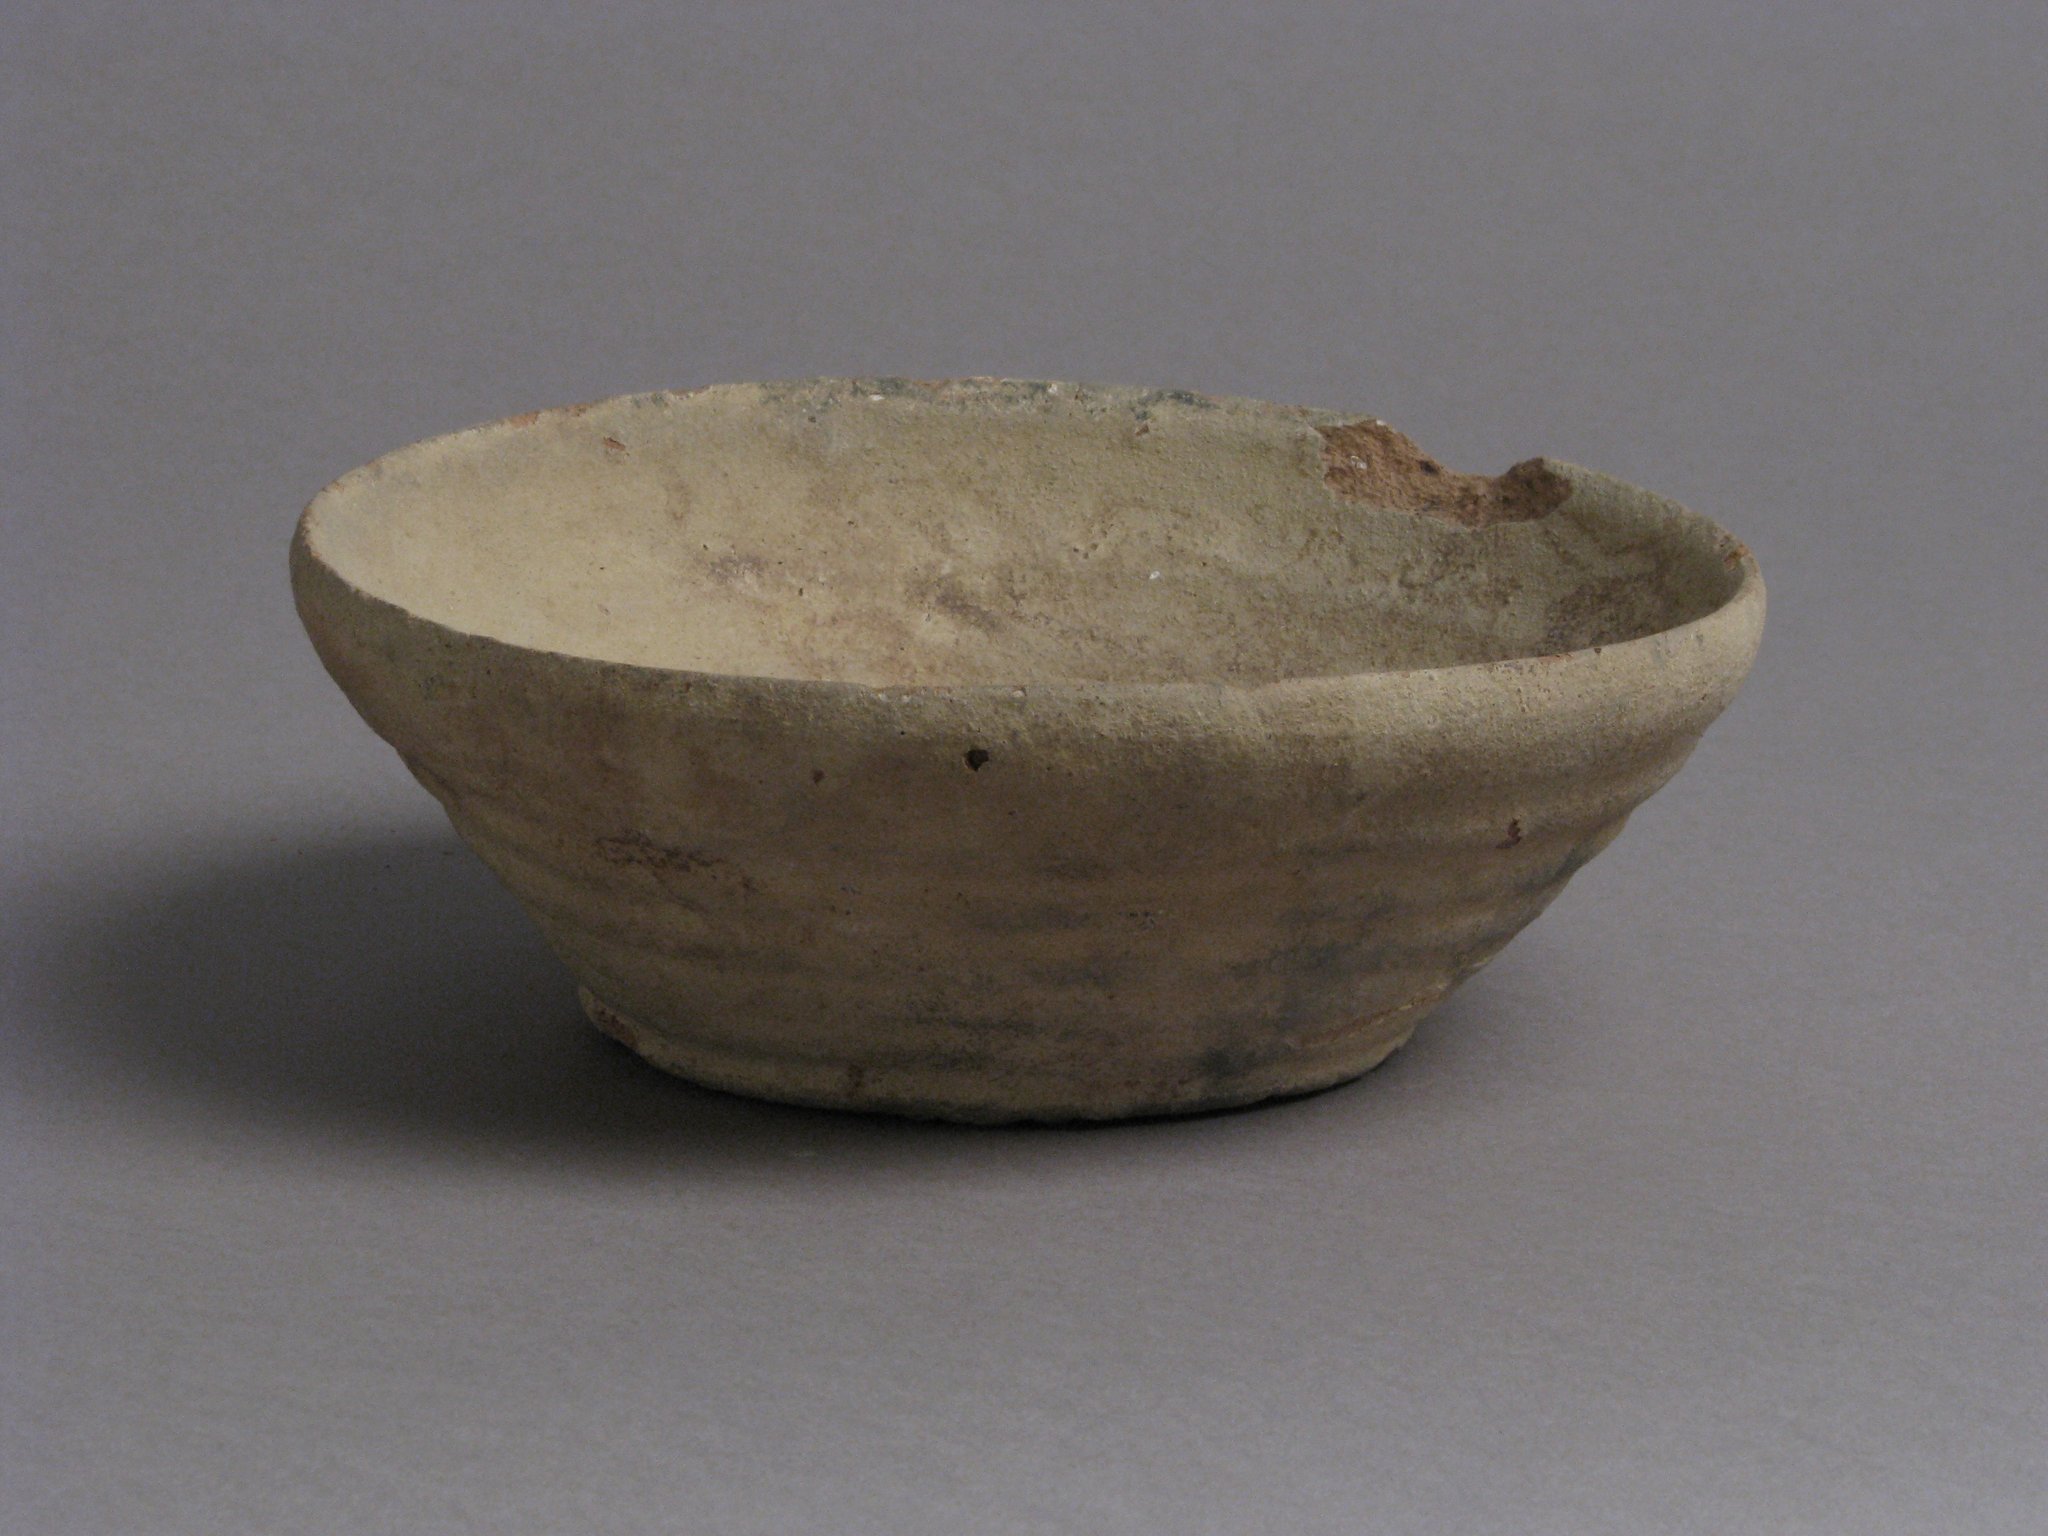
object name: bowl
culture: coptic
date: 301-700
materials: earthenware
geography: egypt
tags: bowls